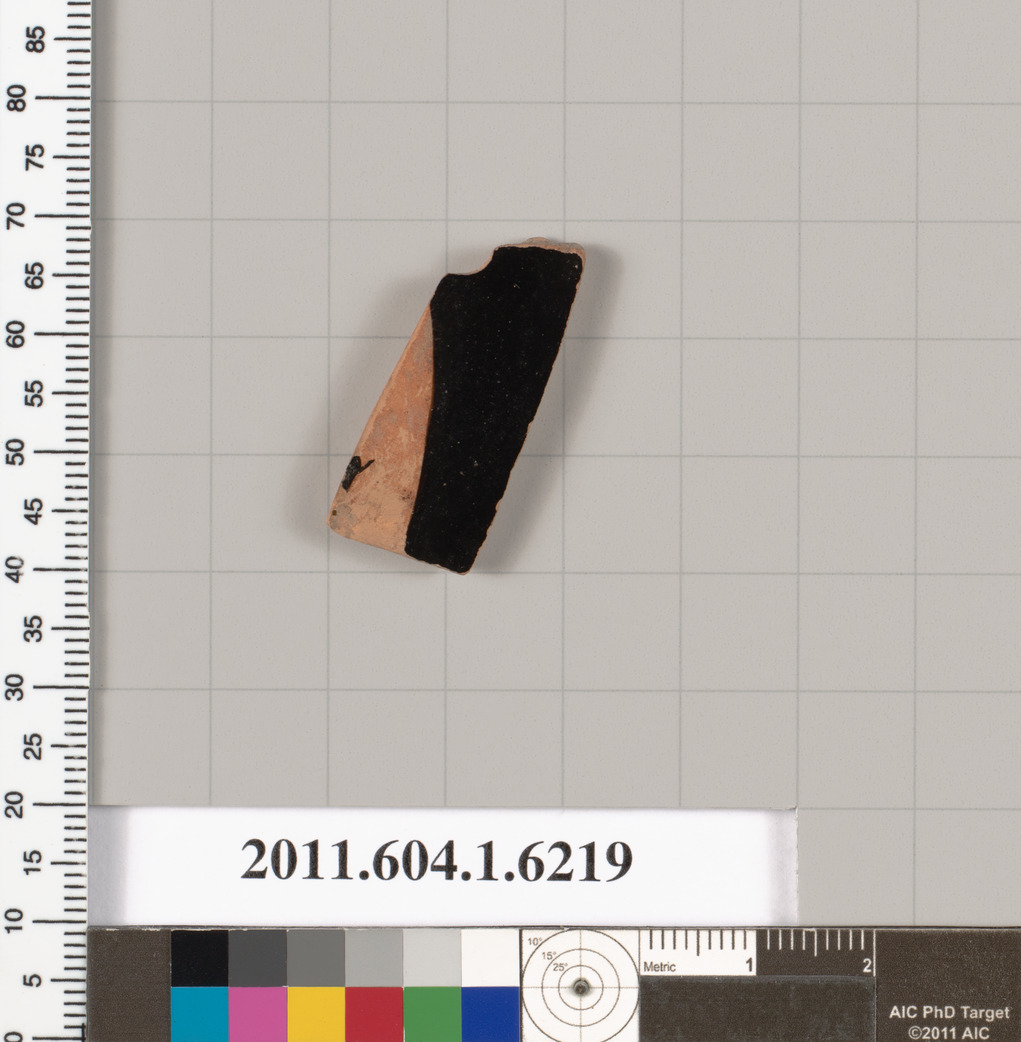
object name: kylix fragment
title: Terracotta fragment of a kylix (drinking cup)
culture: greek, attic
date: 510-500 BCE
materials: terracotta